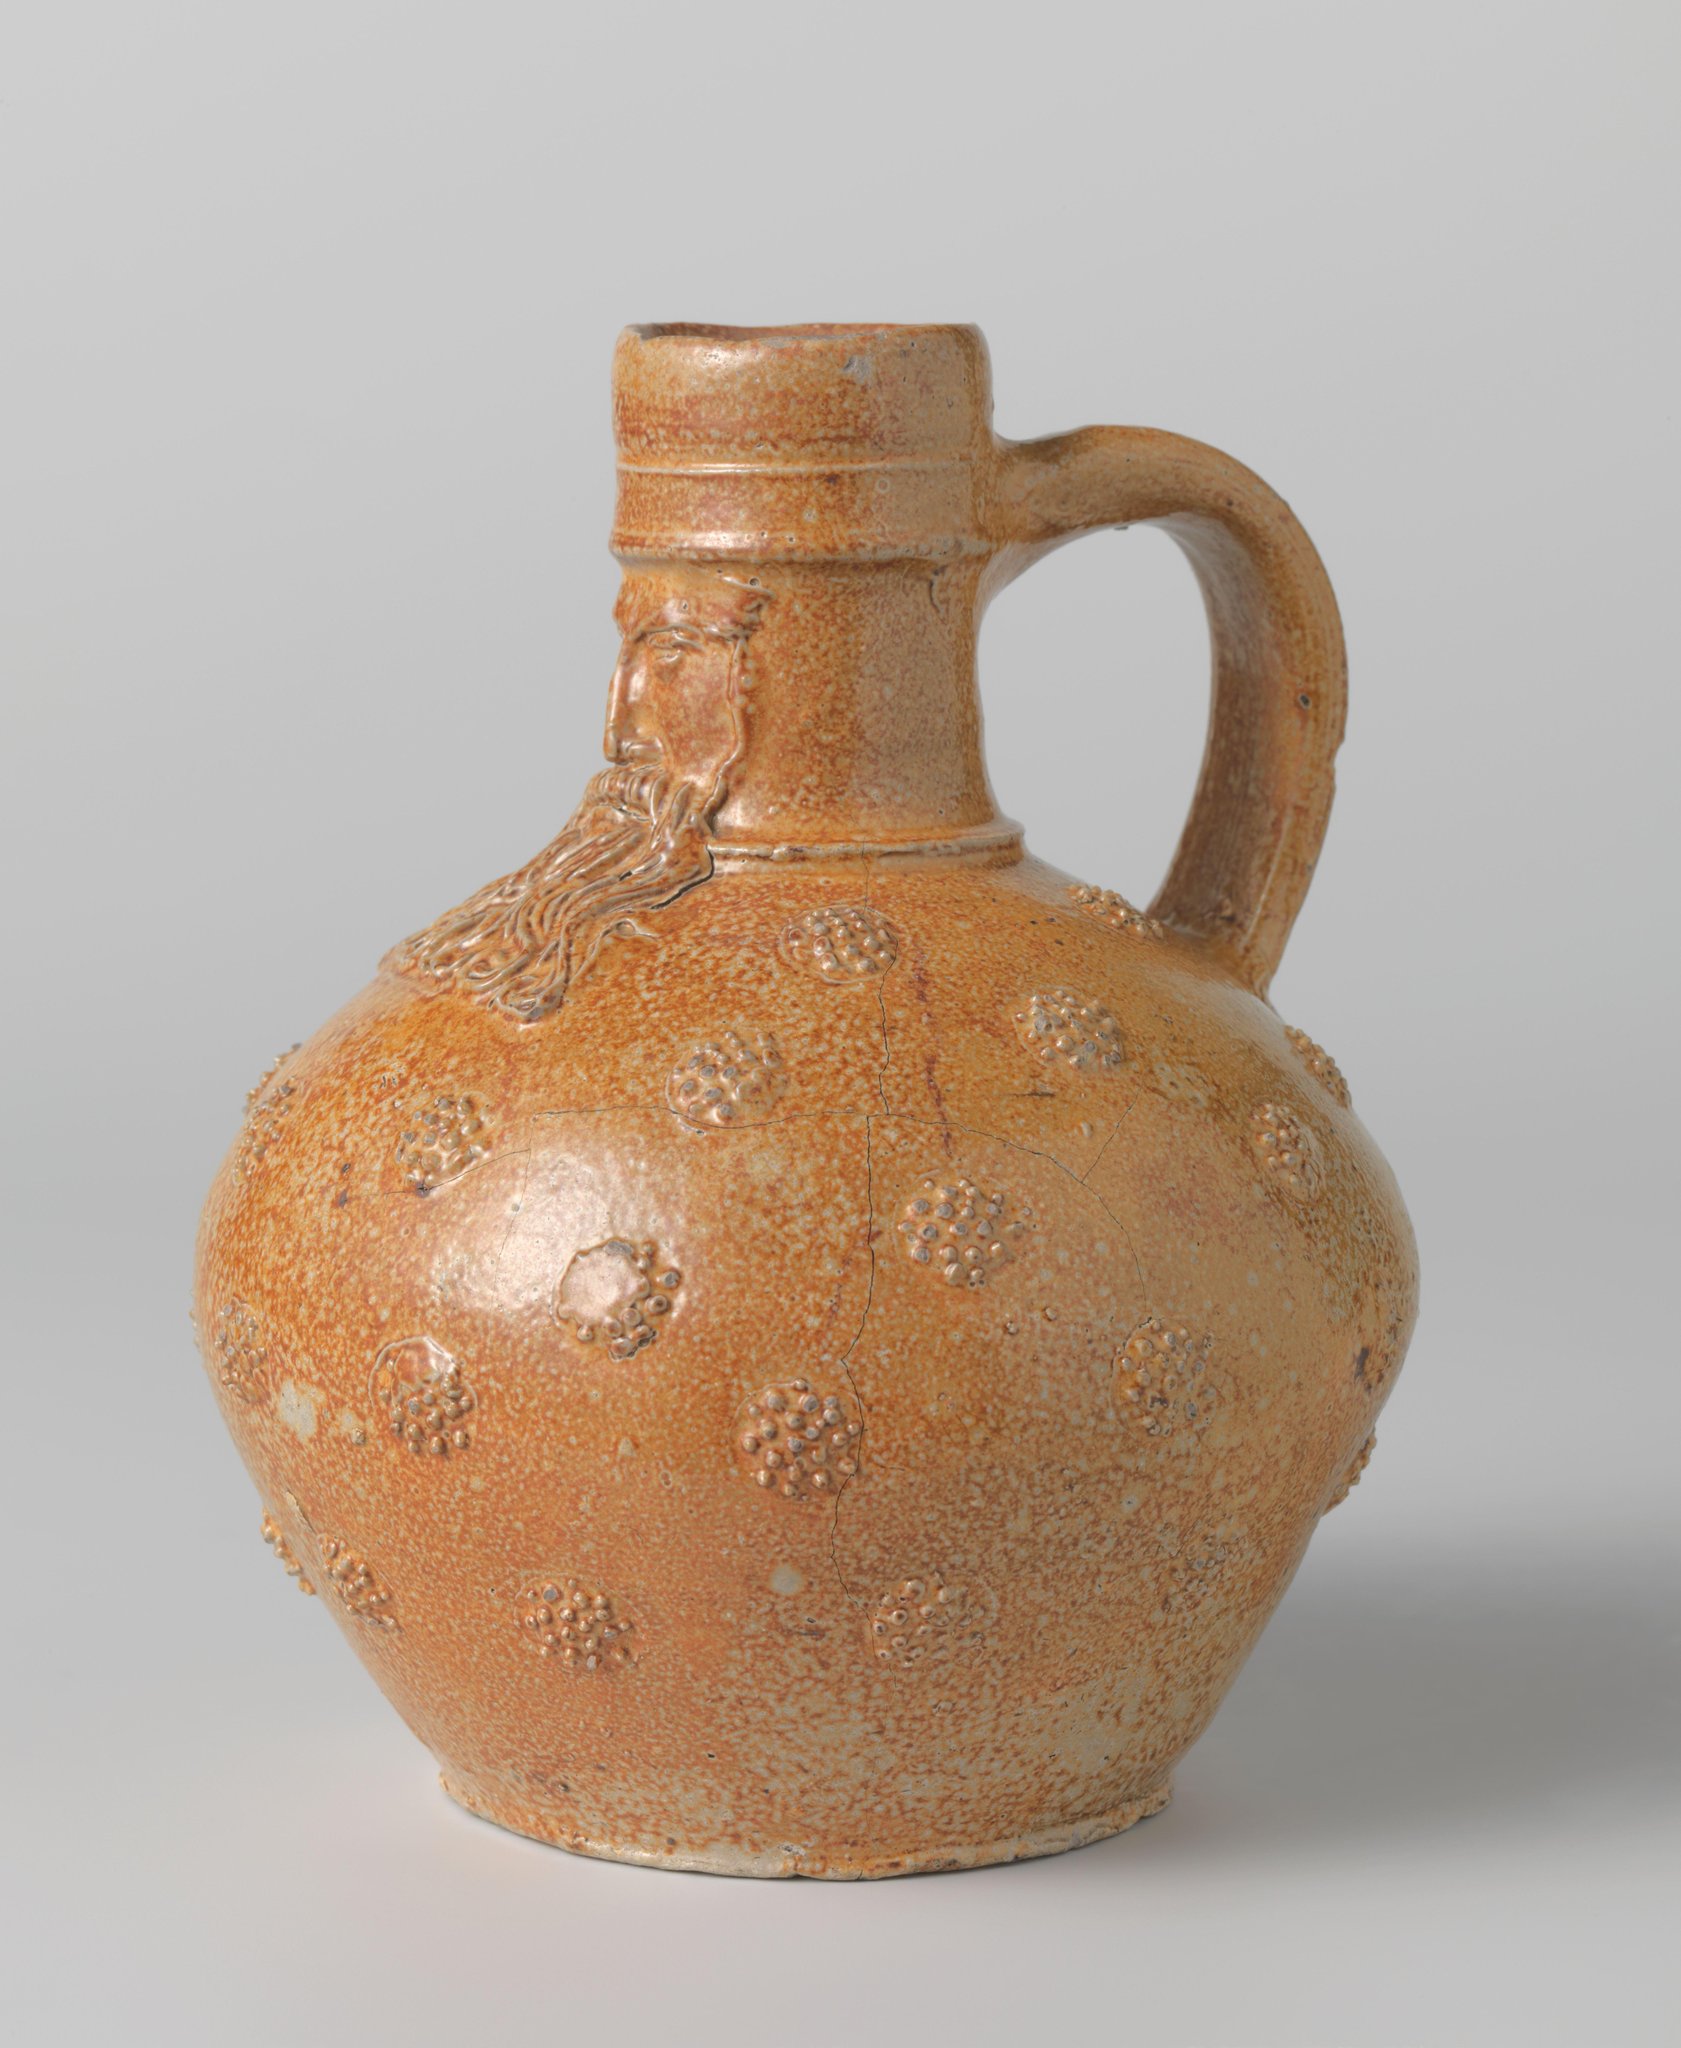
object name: bellarmine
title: Jug (Bartmann jug) with speckled orbs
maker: Anonymous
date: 1530-1560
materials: engobe, glaze, stoneware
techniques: firing, forming, relief, turning, vitrification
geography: frechen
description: Kruik (baardmankruik) van steengoed op standvlak met een bolvormig lichaam en smalle nek. Het C-vormige oor is bevestigd aan de nek en de schouder. Profielen op de nek. Bedekt met een bruine engobe. De buik is bedekt met kleine gedrukte en opgelegde, gestippelde bollen in reliëf. Op de nek, doorlopend op de schouder, een baardman. Keulen/ Frechen.